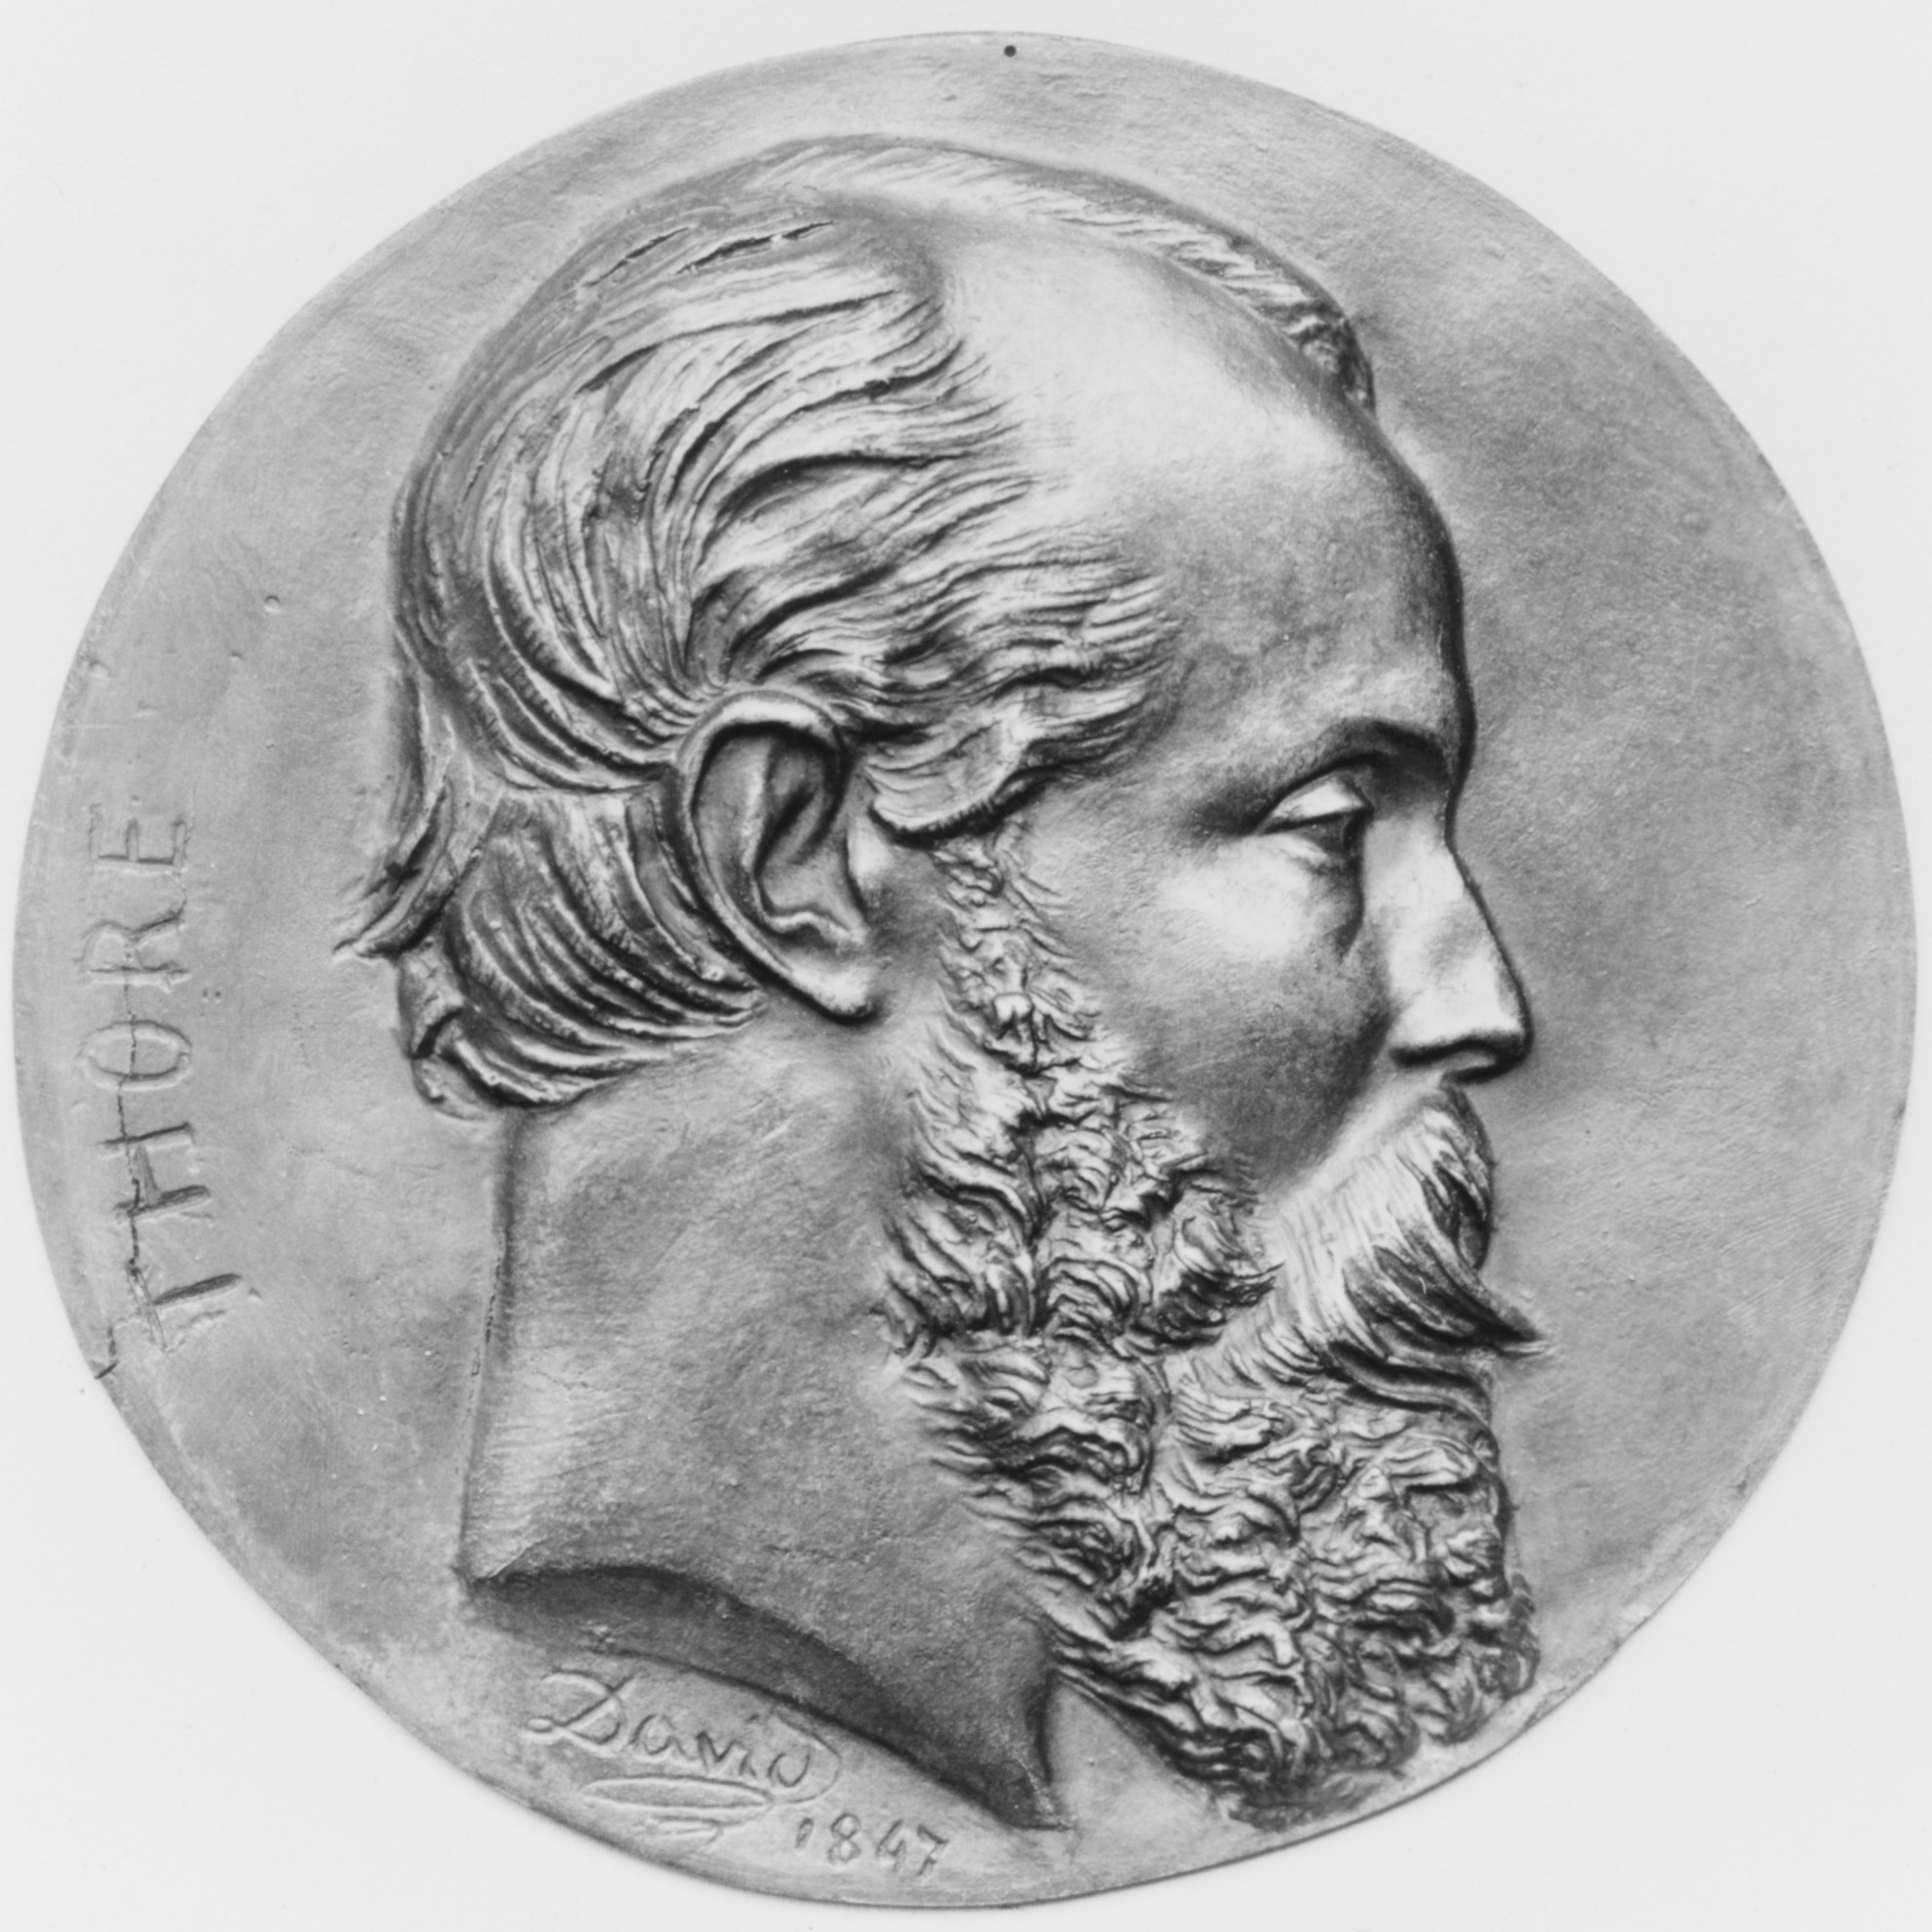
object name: medallion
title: Théophile Thoré (1807–1869), French critic and editor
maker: pierre jean david d'angers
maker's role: artist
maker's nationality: french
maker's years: 1788-1856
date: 1847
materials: bronze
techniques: casting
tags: men,profiles